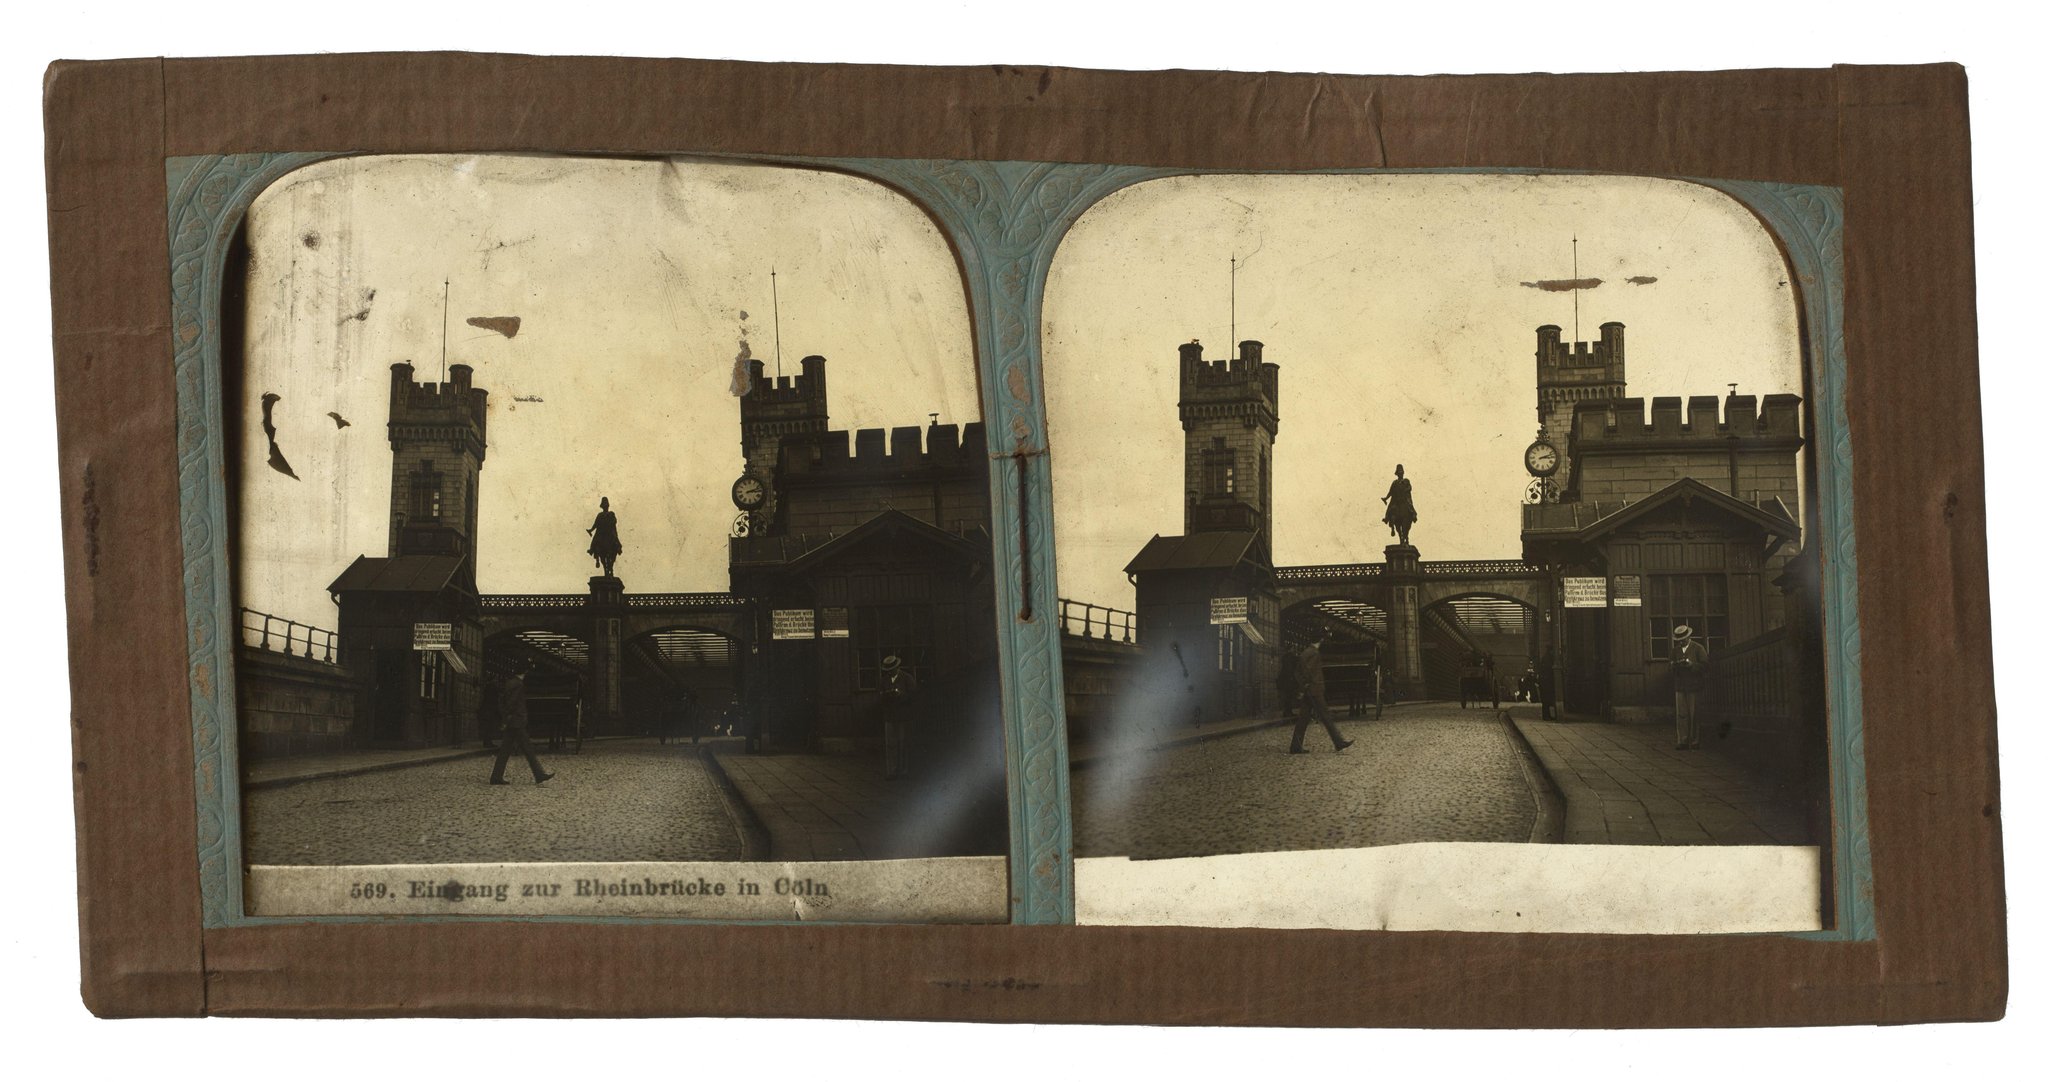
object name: stereograph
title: Eingang zur Rheinbrucke in Cöln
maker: Anonymous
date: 1900-1940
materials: cardboard, film, metal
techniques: gelatin silver print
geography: cologne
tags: bridge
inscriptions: number: ‘569.’